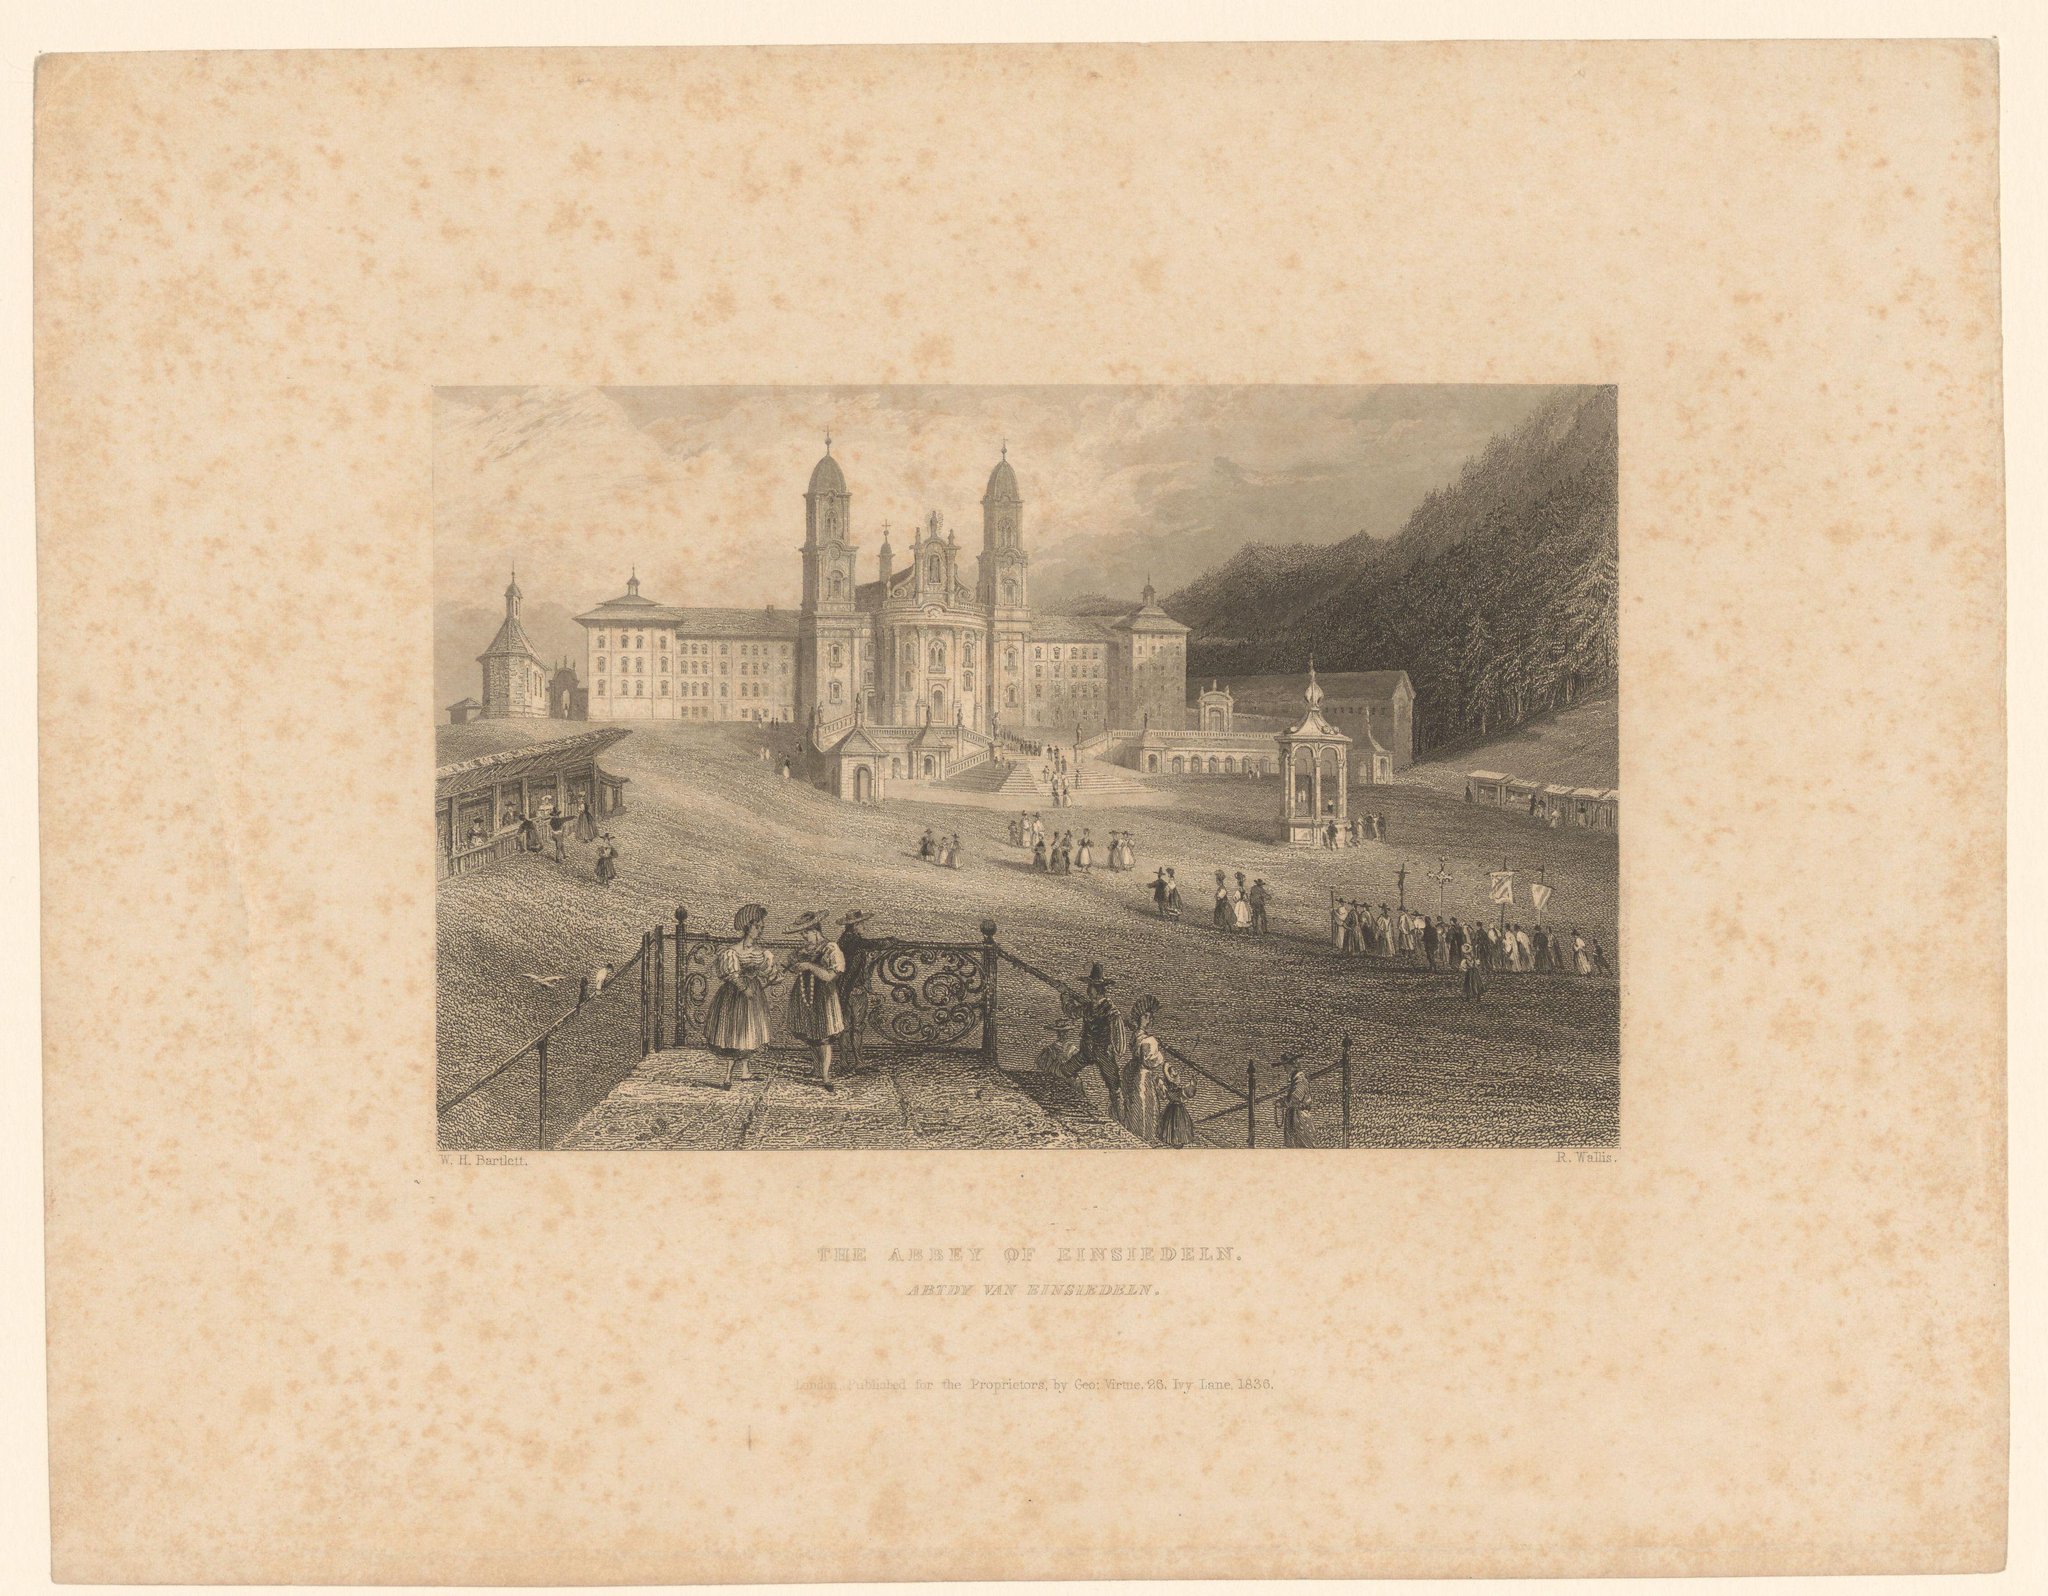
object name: print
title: Gezicht op de Abdij Maria Einsiedeln in Schwyz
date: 1836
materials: paper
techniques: engraving, etching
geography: london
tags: abbey, monastery, convent ~ roman catholic church, mountains (+ landscape with figures, staffage)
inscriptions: collector's mark: Lugt 2233